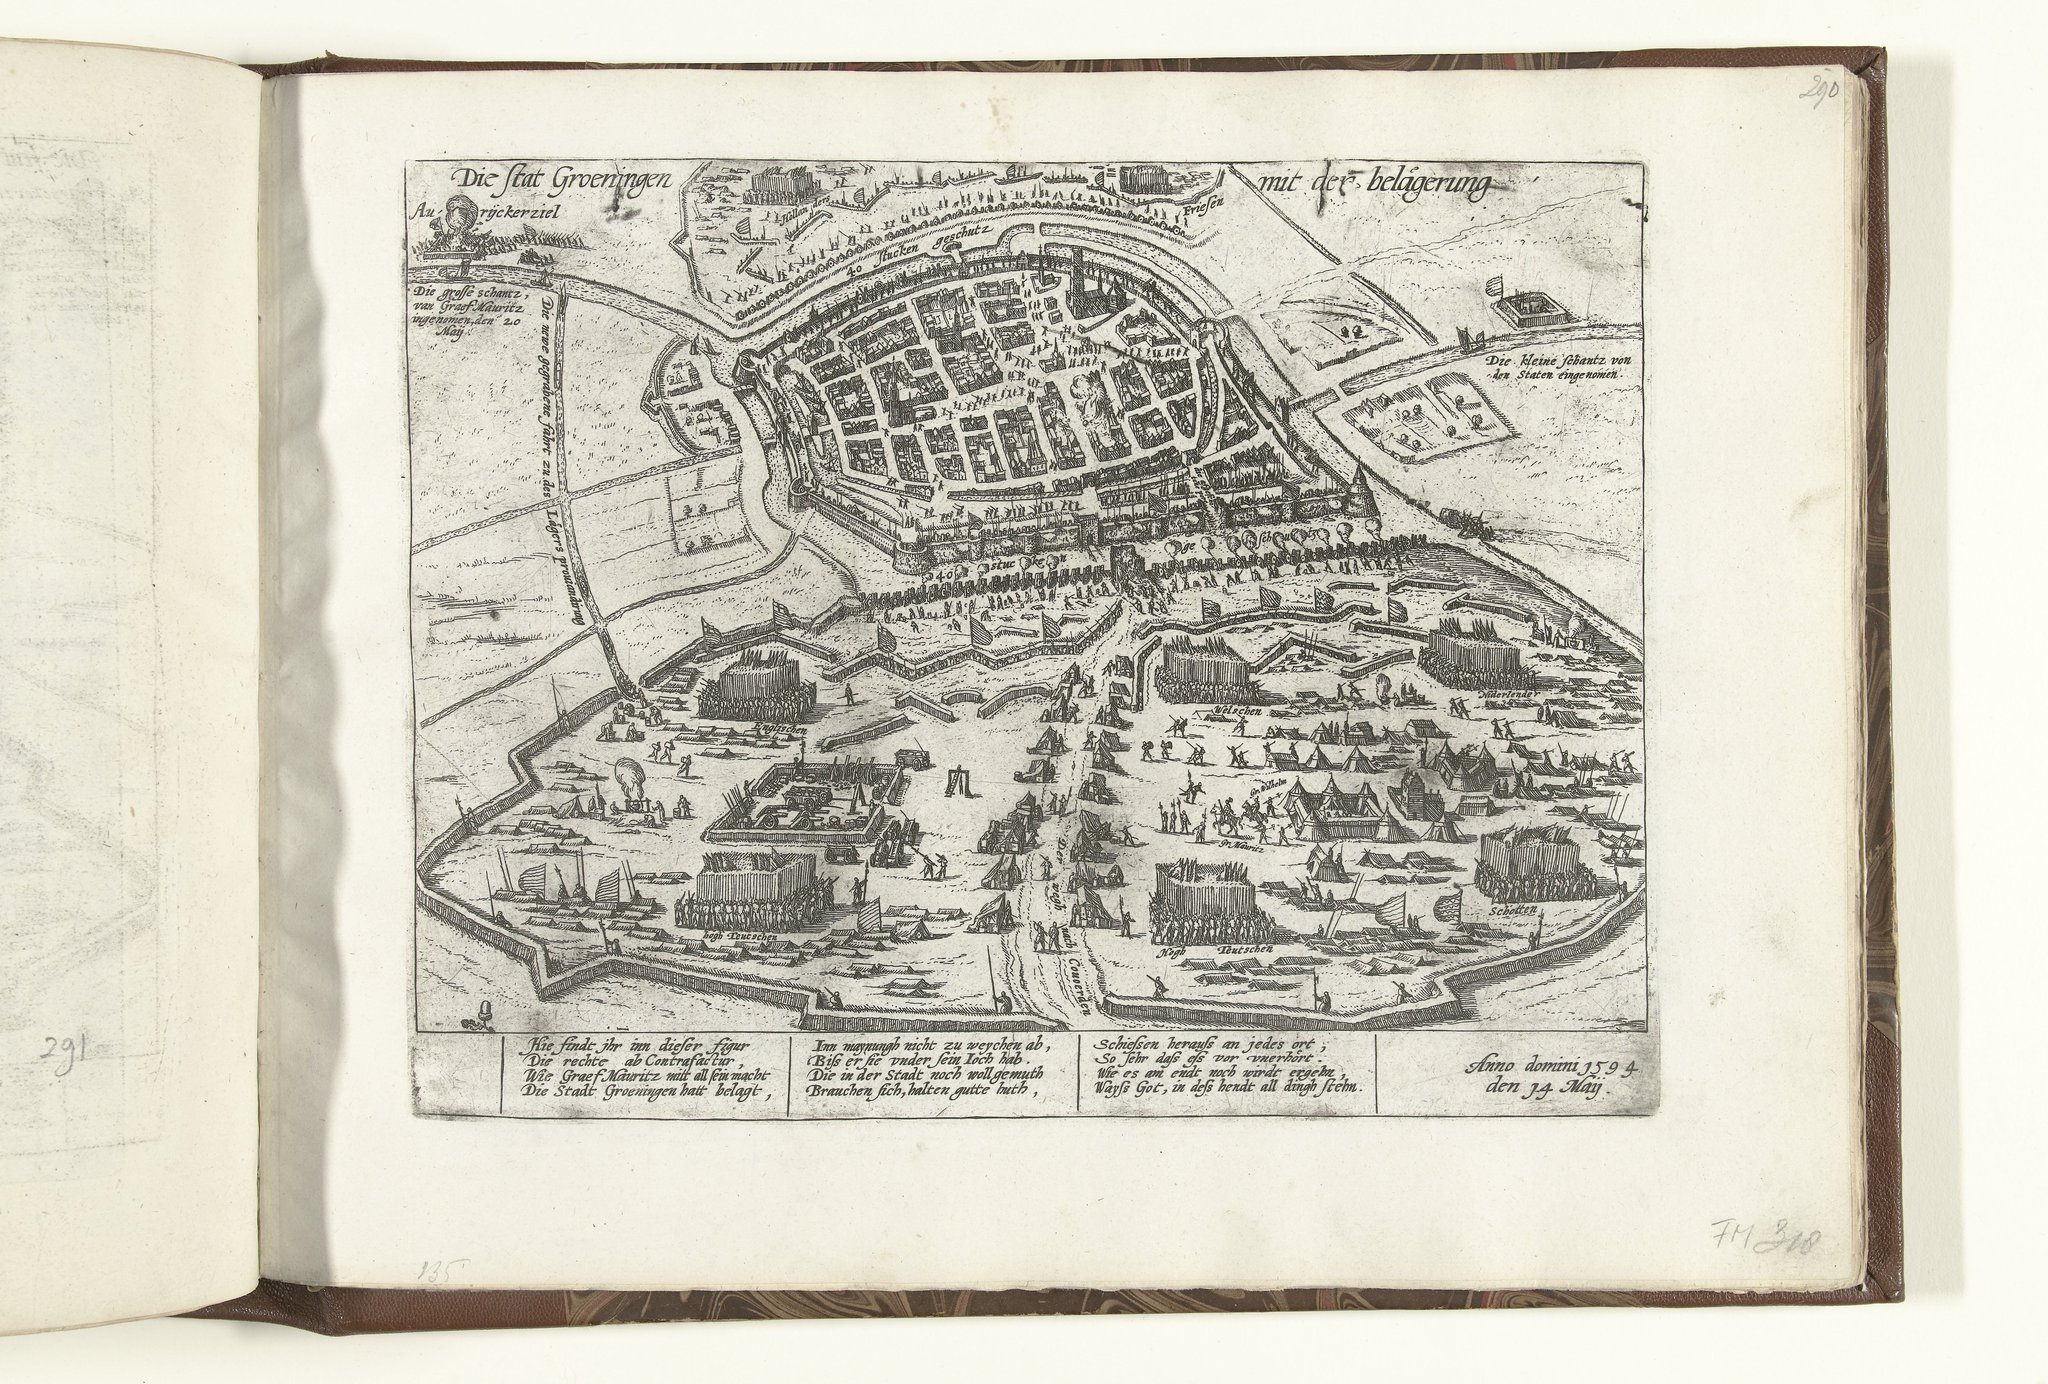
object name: album leaf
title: Serie 10: Nederlandse en Buitenlandse Gebeurtenissen, 1587-1612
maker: frans hogenberg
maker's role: print maker, publisher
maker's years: 1538-1590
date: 1594-1596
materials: paper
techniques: etching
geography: cologne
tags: the hague, maurice (prince of orange), willem lodewijk graaf van nassau-dillenburg, siege, position war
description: Belegering van Groningen door het leger van Maurits. Op de voorgrond het legerkamp van het Staatse leger omgeven door schansen. Boven de ommuurde stad. Met onderschrift van 12 regels in het Duits. Ongenummerd.